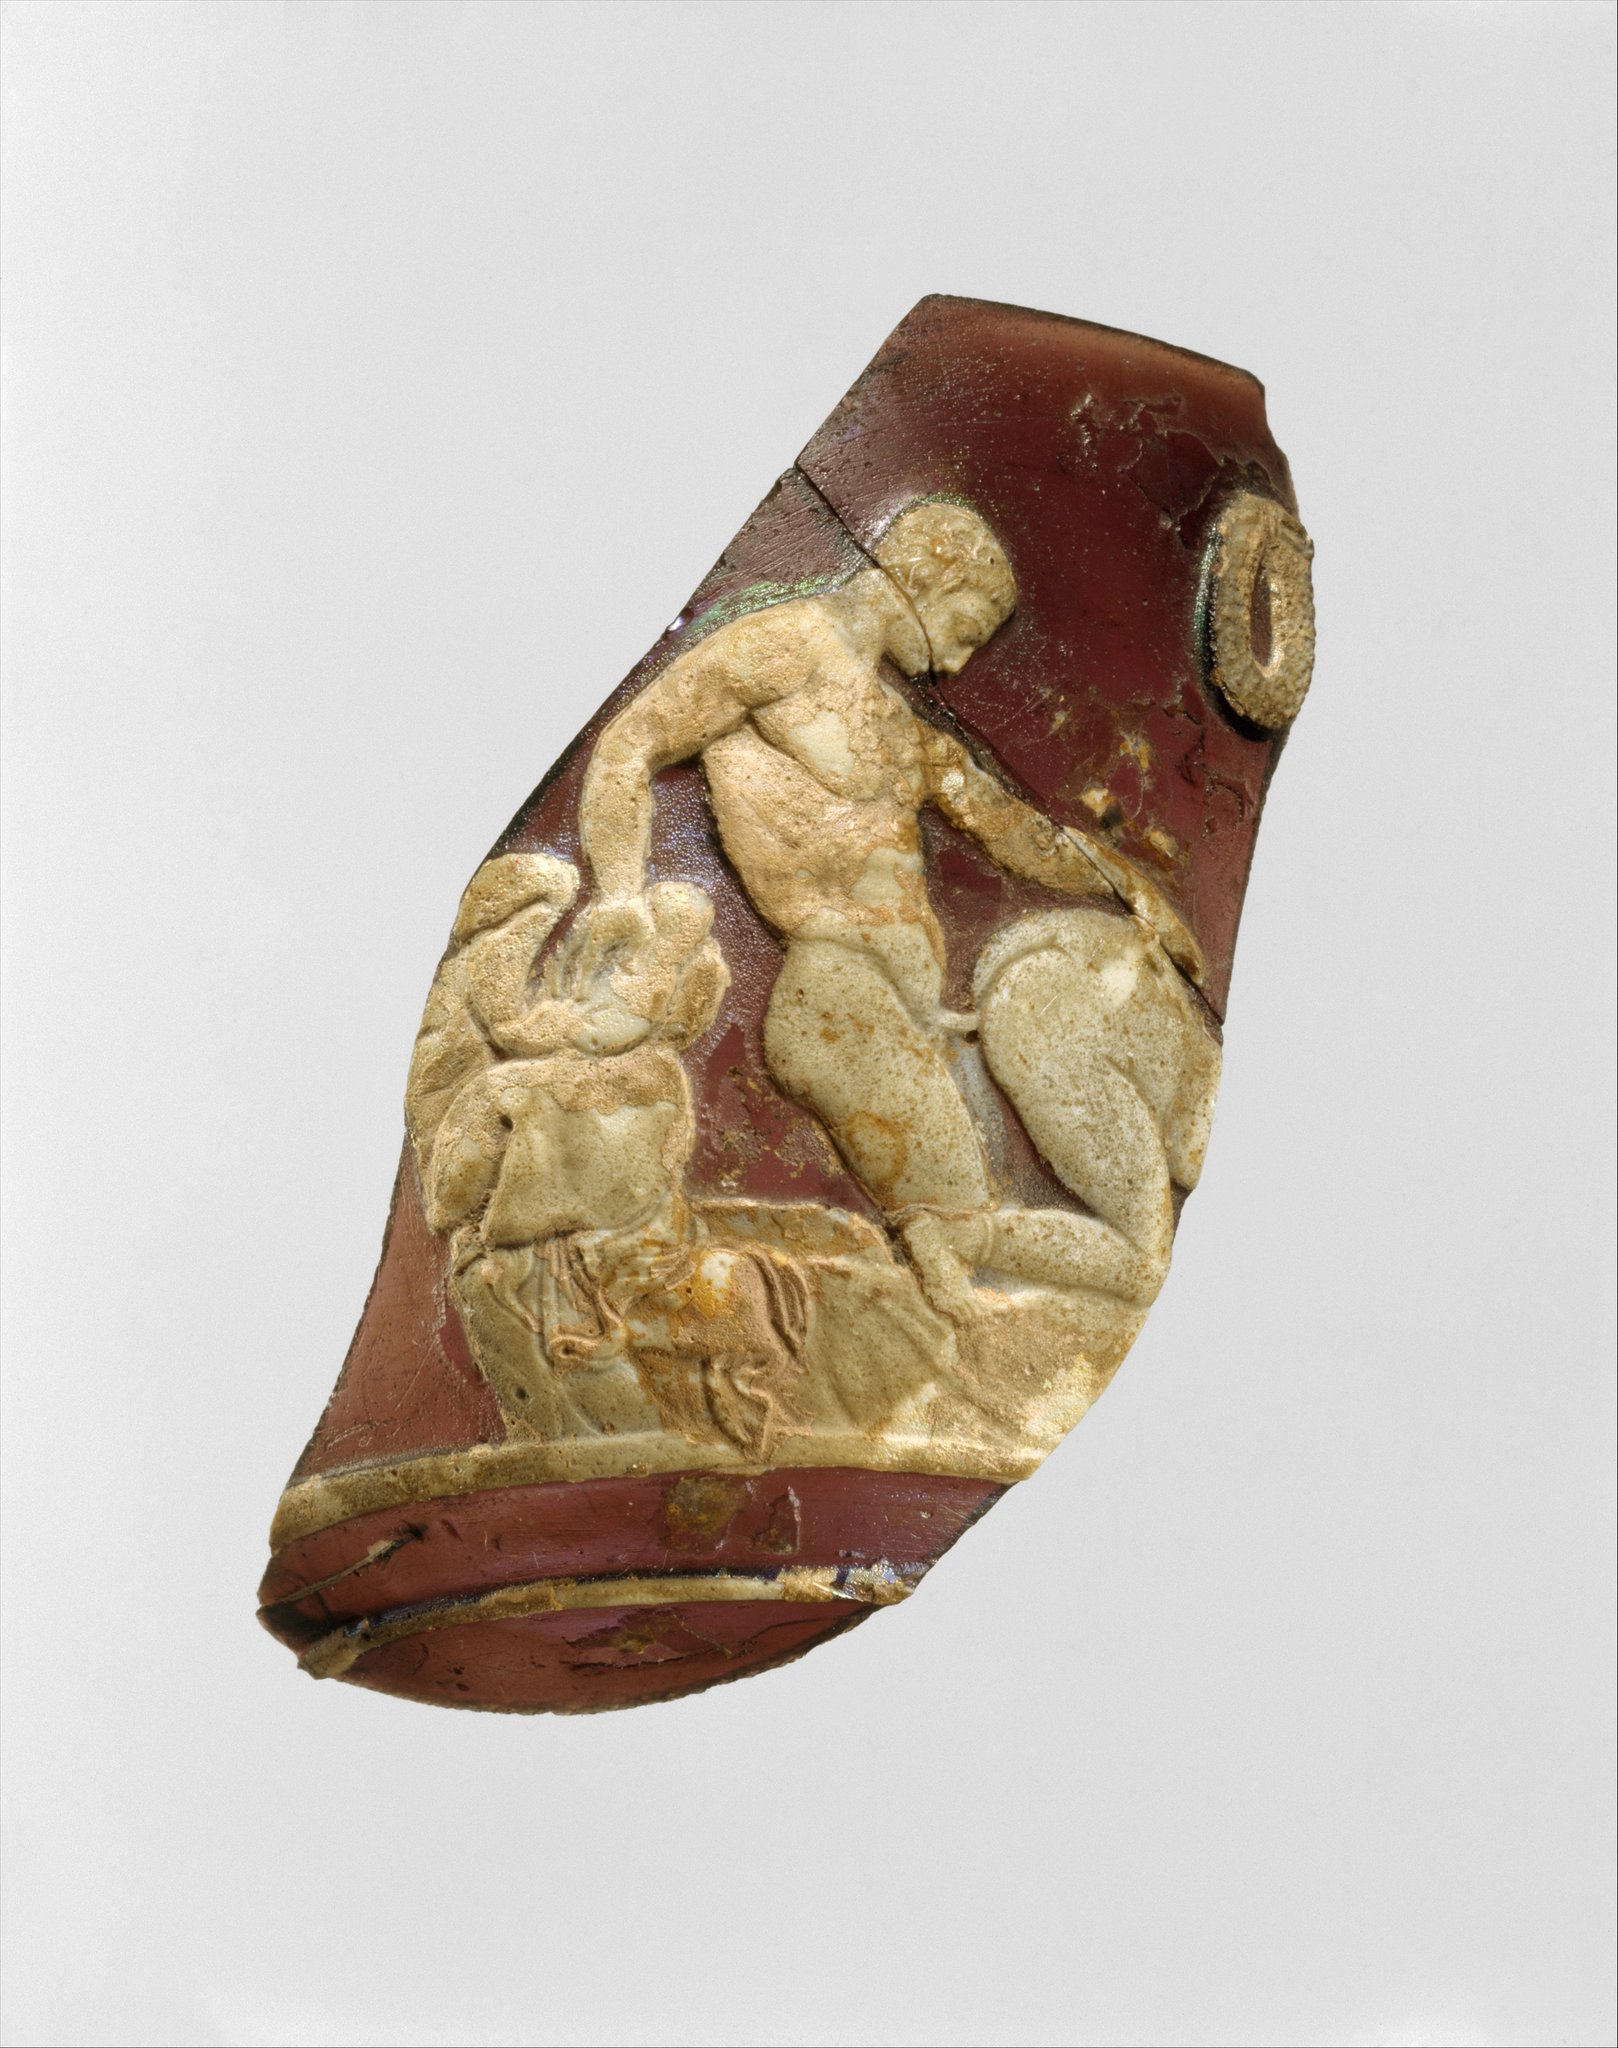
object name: cameo cup fragment, symplegma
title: Glass cameo cup fragment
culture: roman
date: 1-50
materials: glass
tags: male nudes